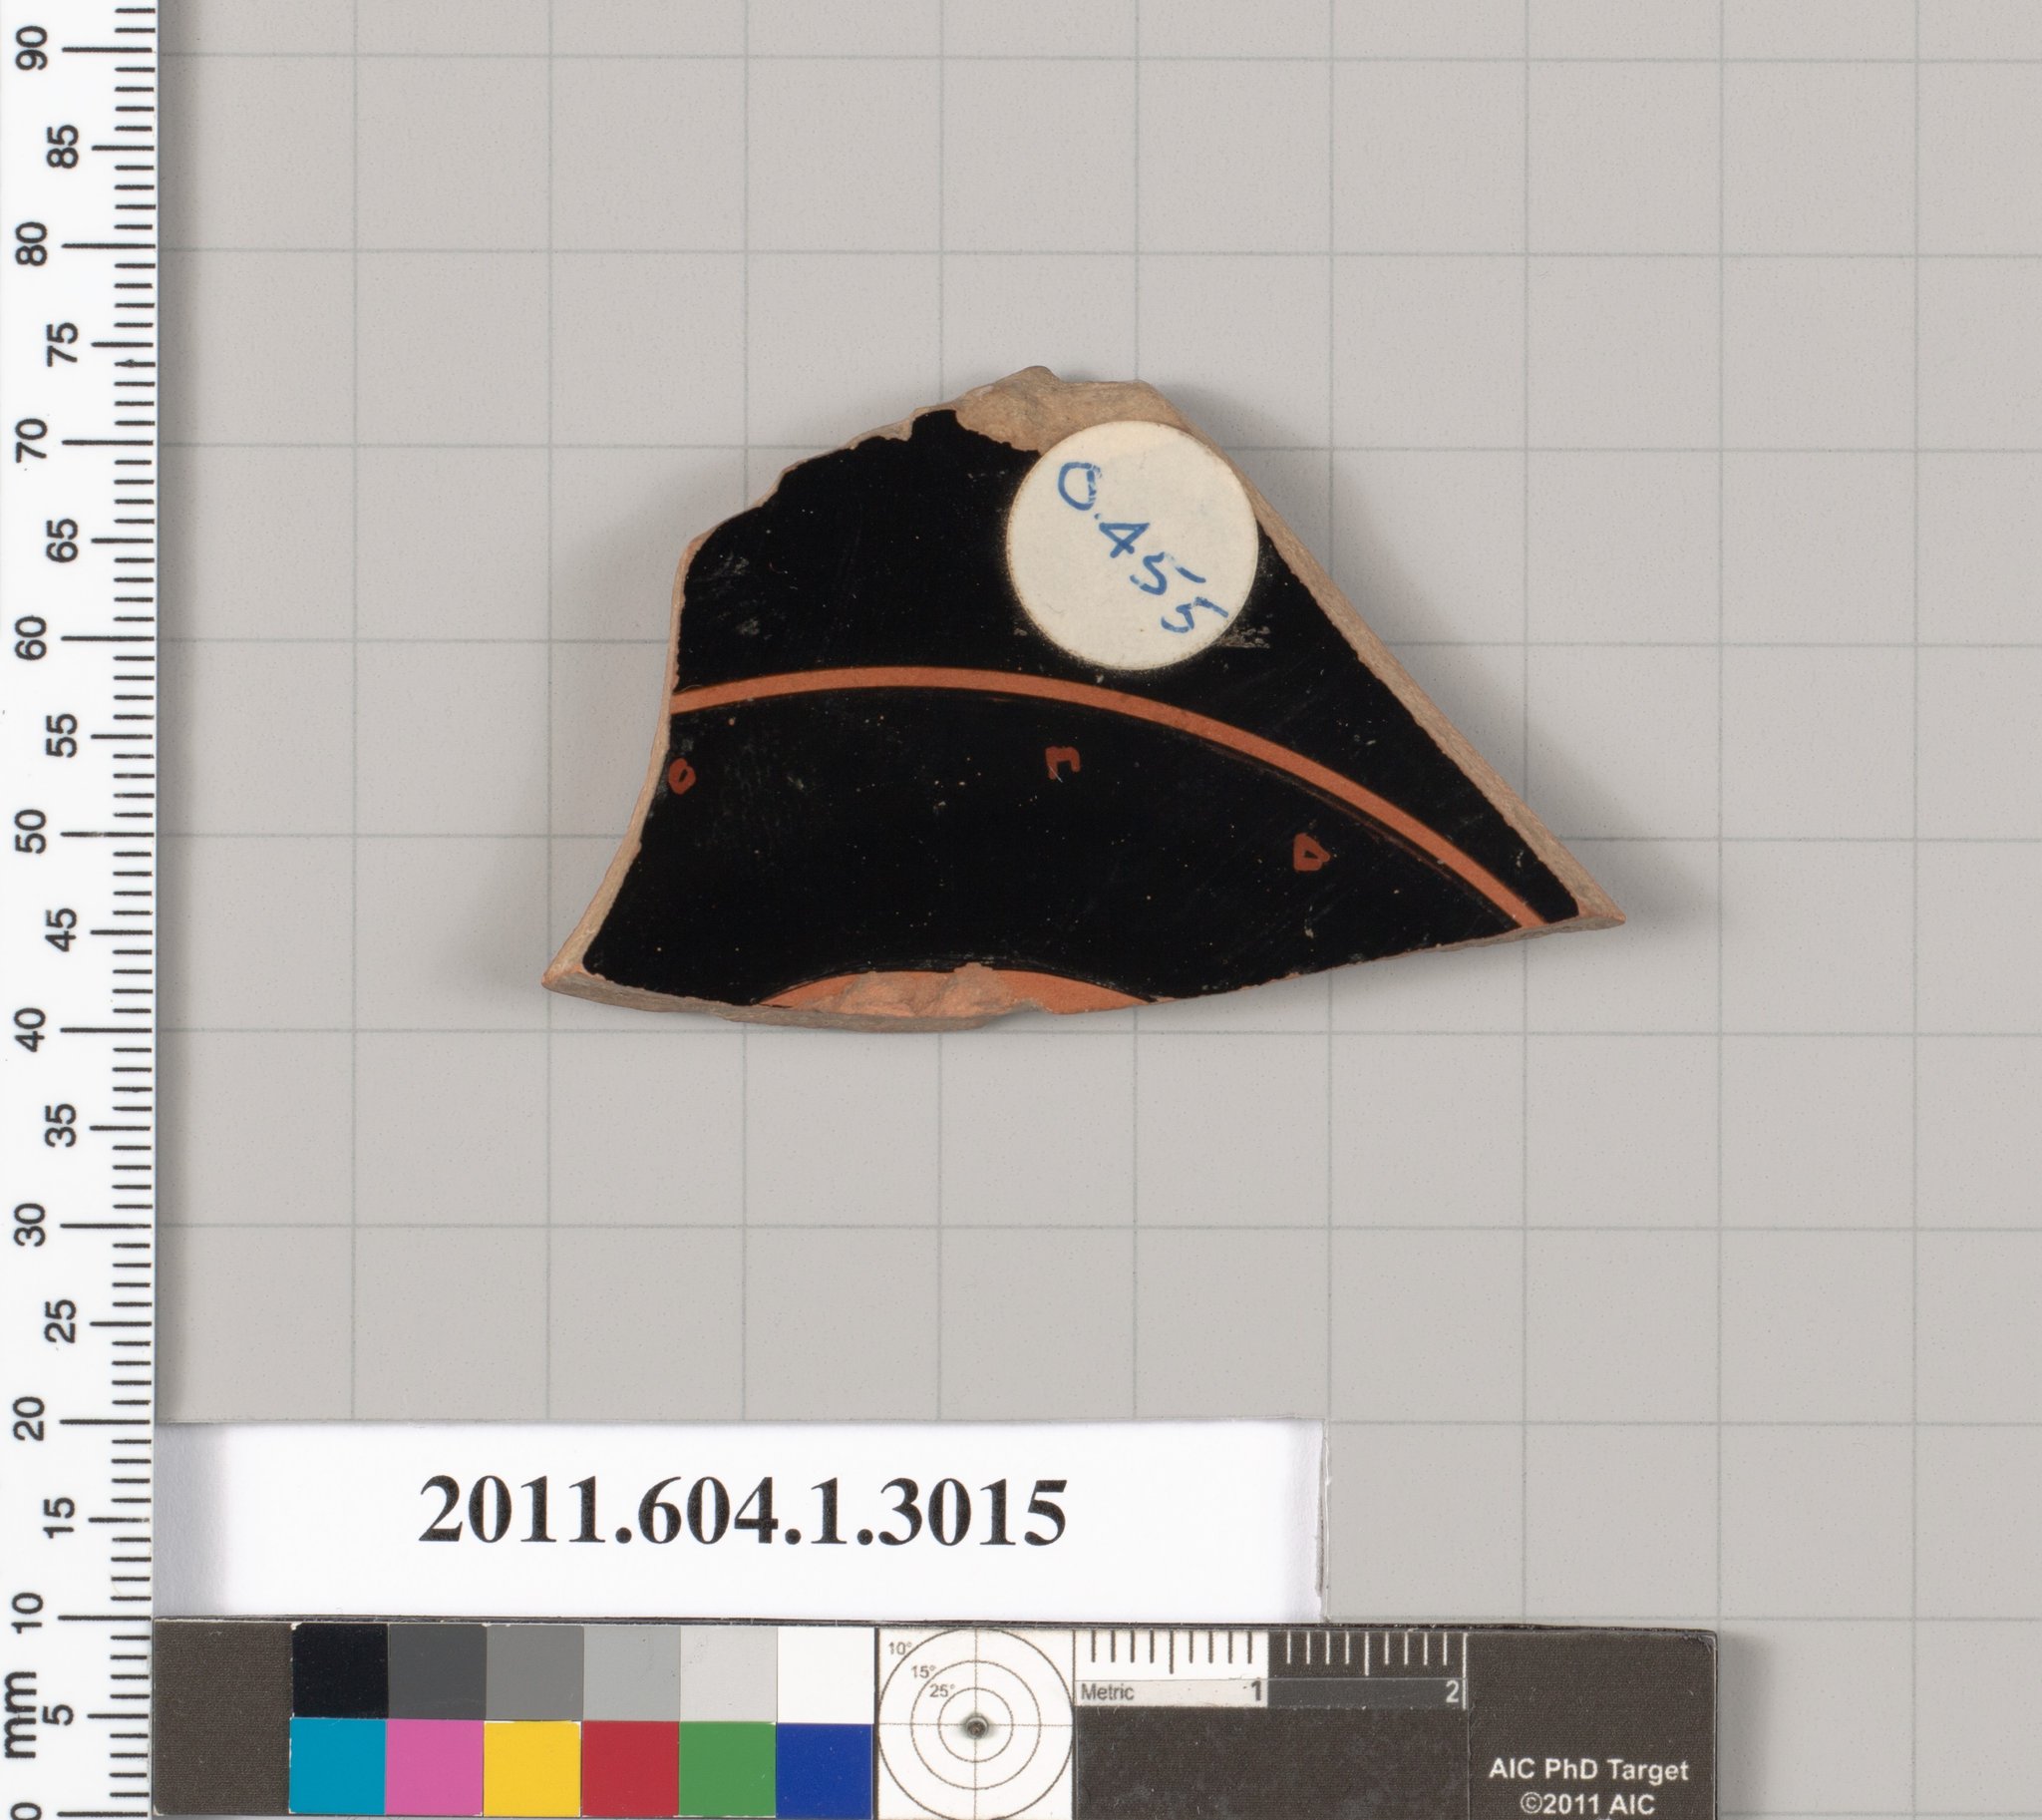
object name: kylix fragment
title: Terracotta fragment of a kylix (drinking cup)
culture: greek, attic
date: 520-500 BCE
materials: terracotta